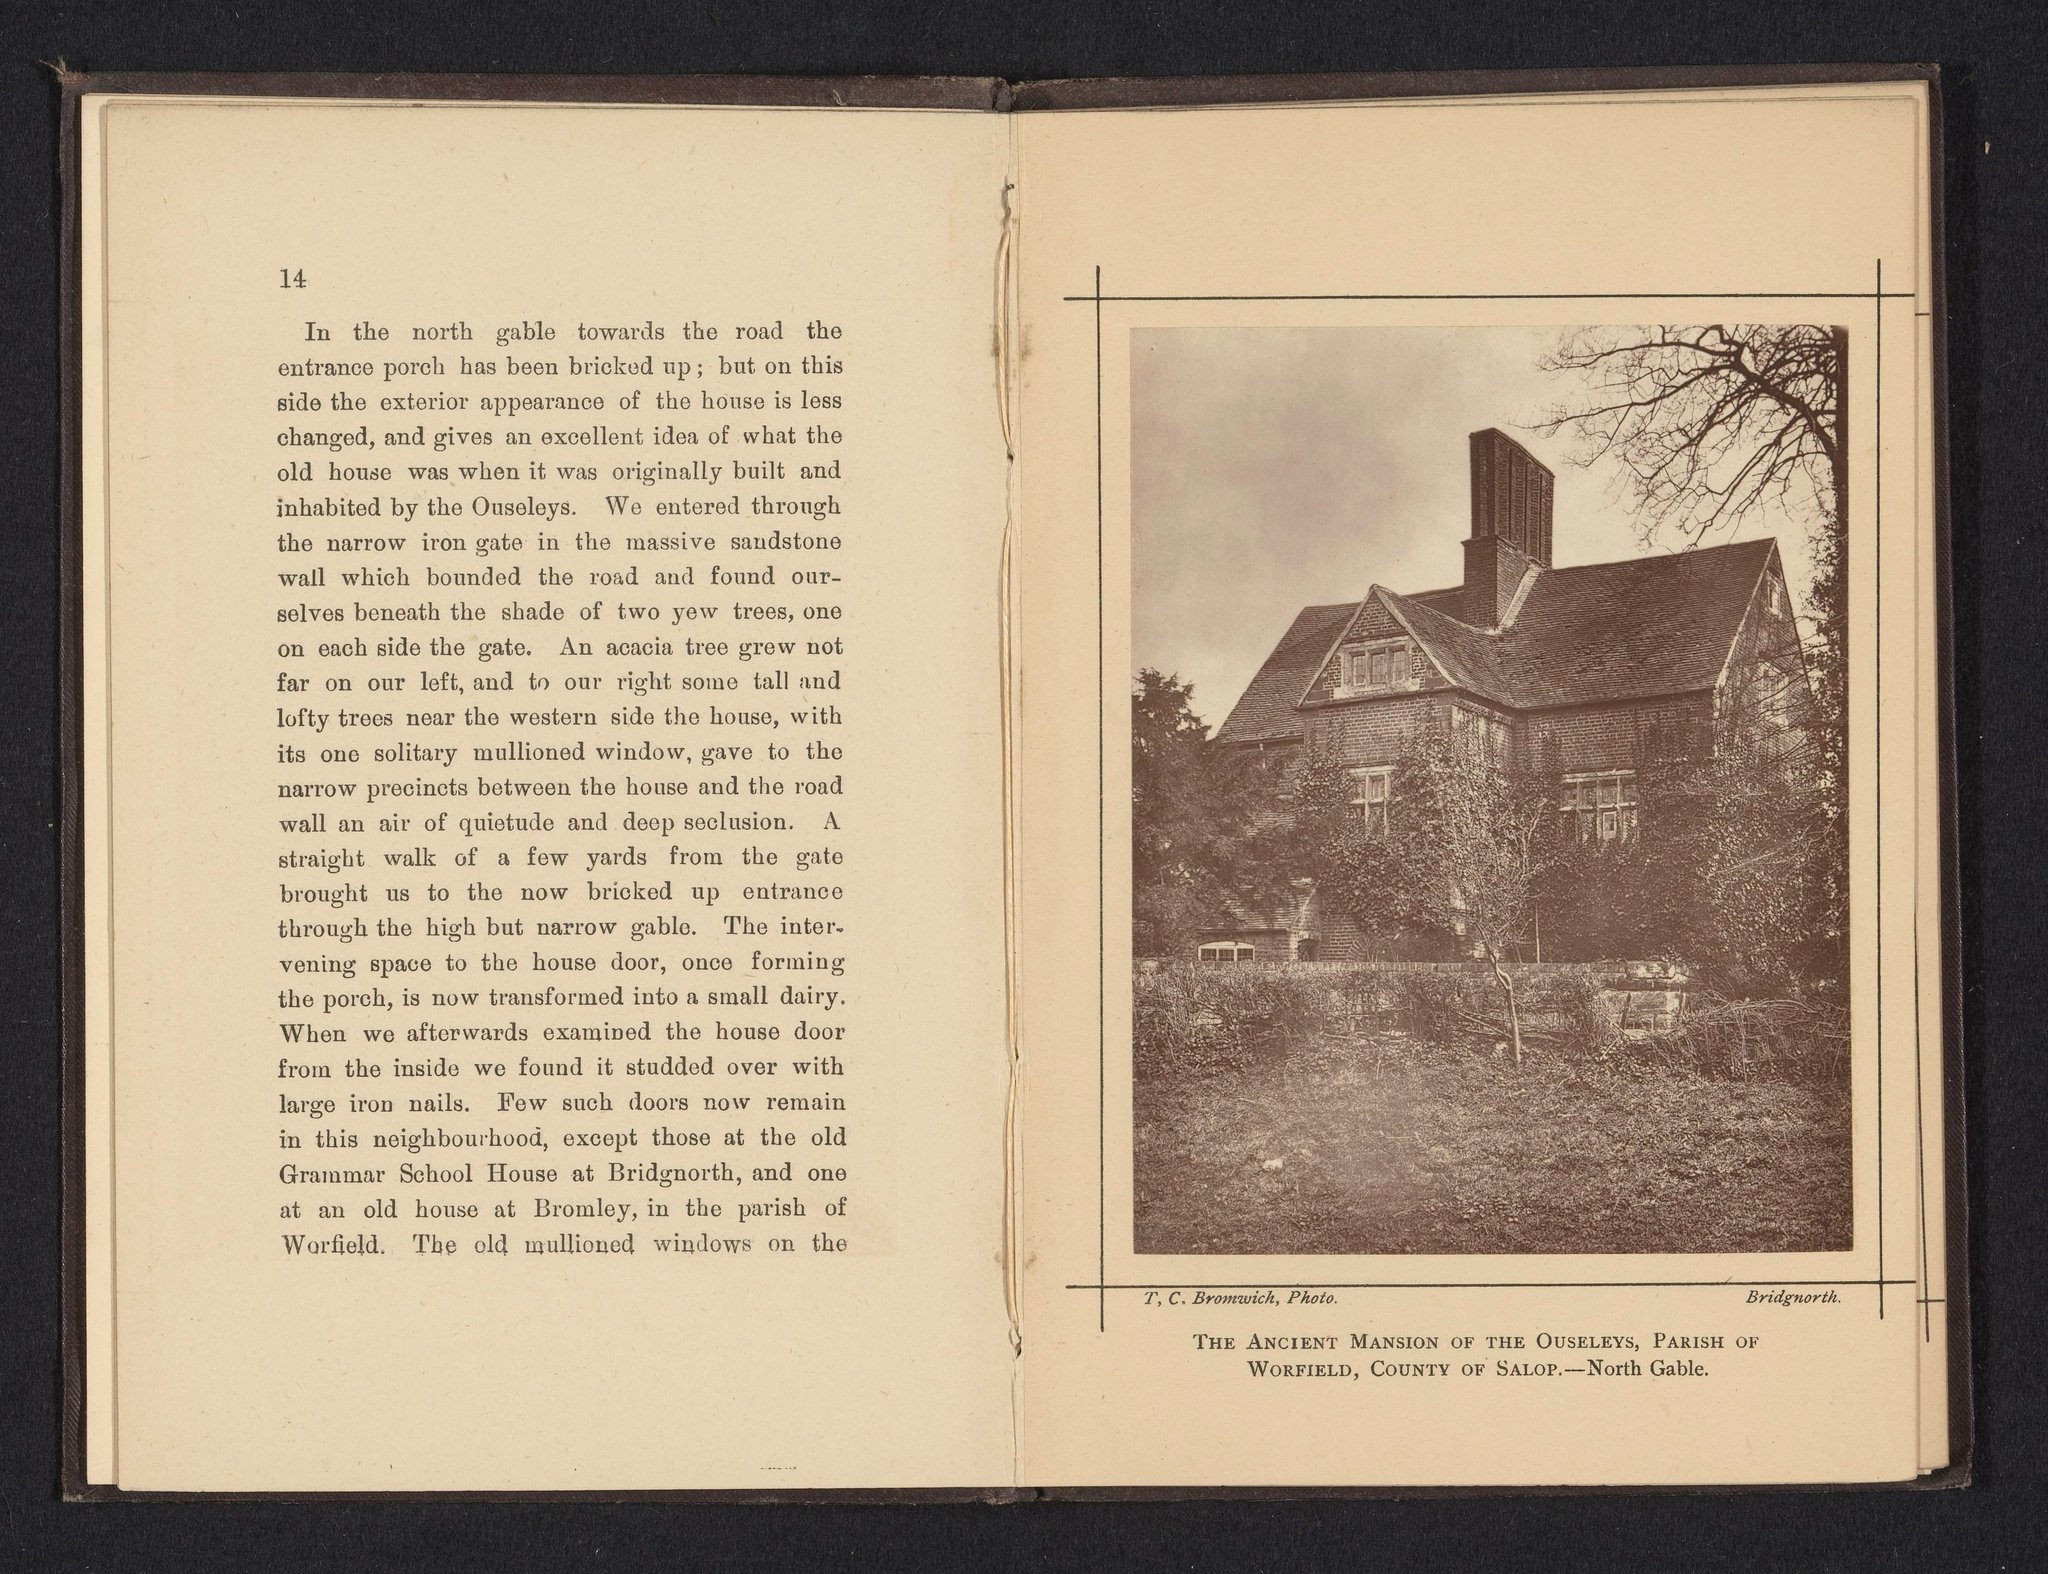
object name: photomechanical print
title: Gezicht op het geboortehuis van William Hardwicke te Allscote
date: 1874-1879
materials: paper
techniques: woodburytype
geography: worfield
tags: housing, façade (of house or building)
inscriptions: inscription: ‘The ancient mansion (...) North Gable.’